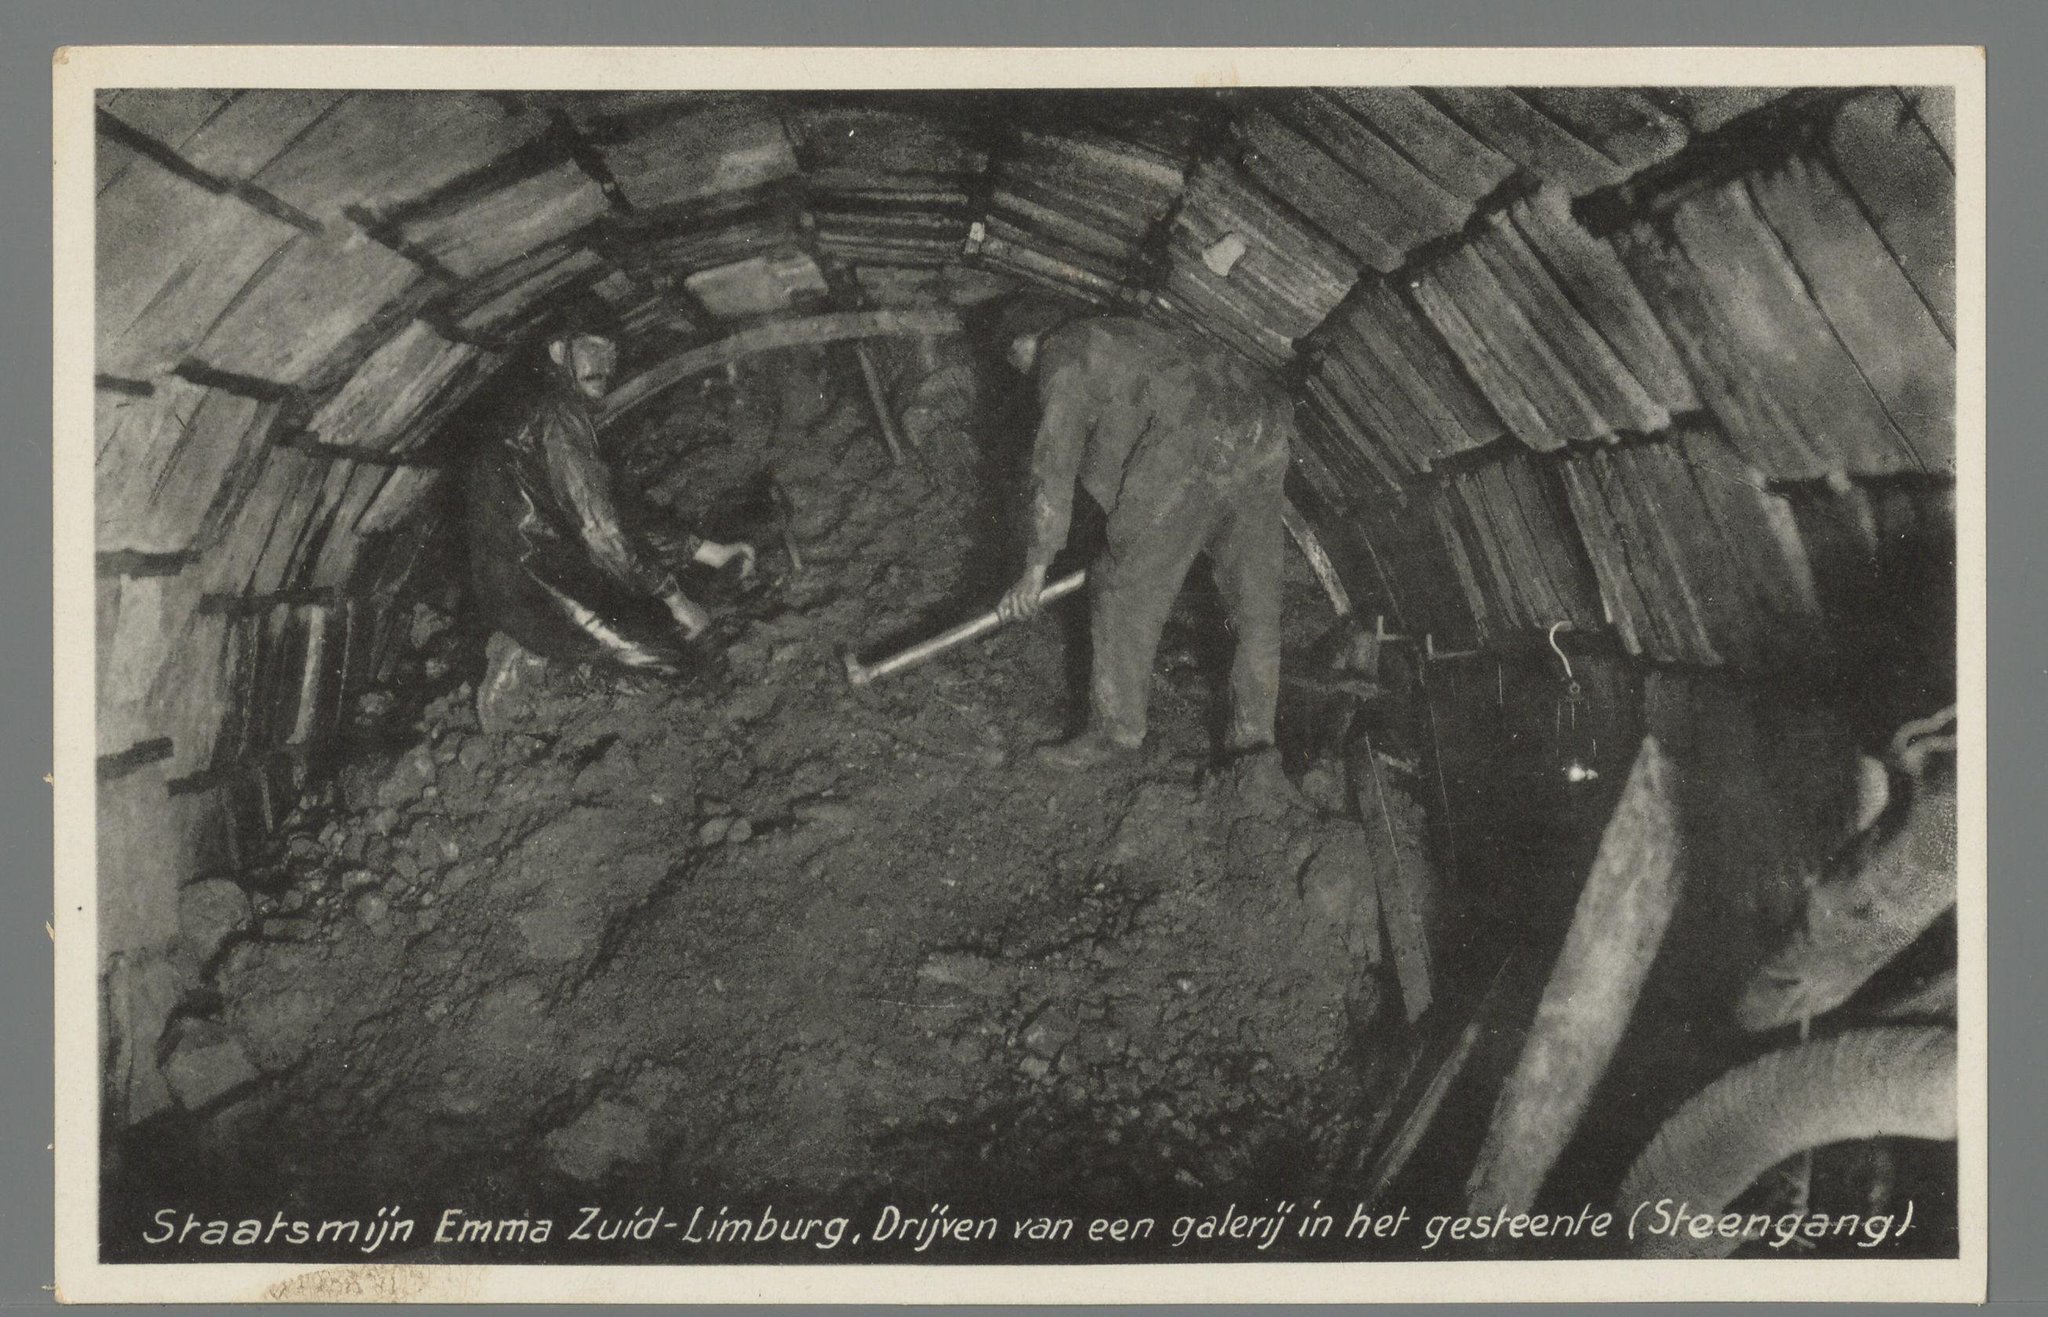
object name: photomechanical print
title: Staatsmijn Emma Zuid-Limburg. Drijven van een galerij in het gesteende (steengang)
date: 1933-1950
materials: cardboard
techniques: photograph, writing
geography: ubach over worms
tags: miner, shafts and galleries (of a mine)